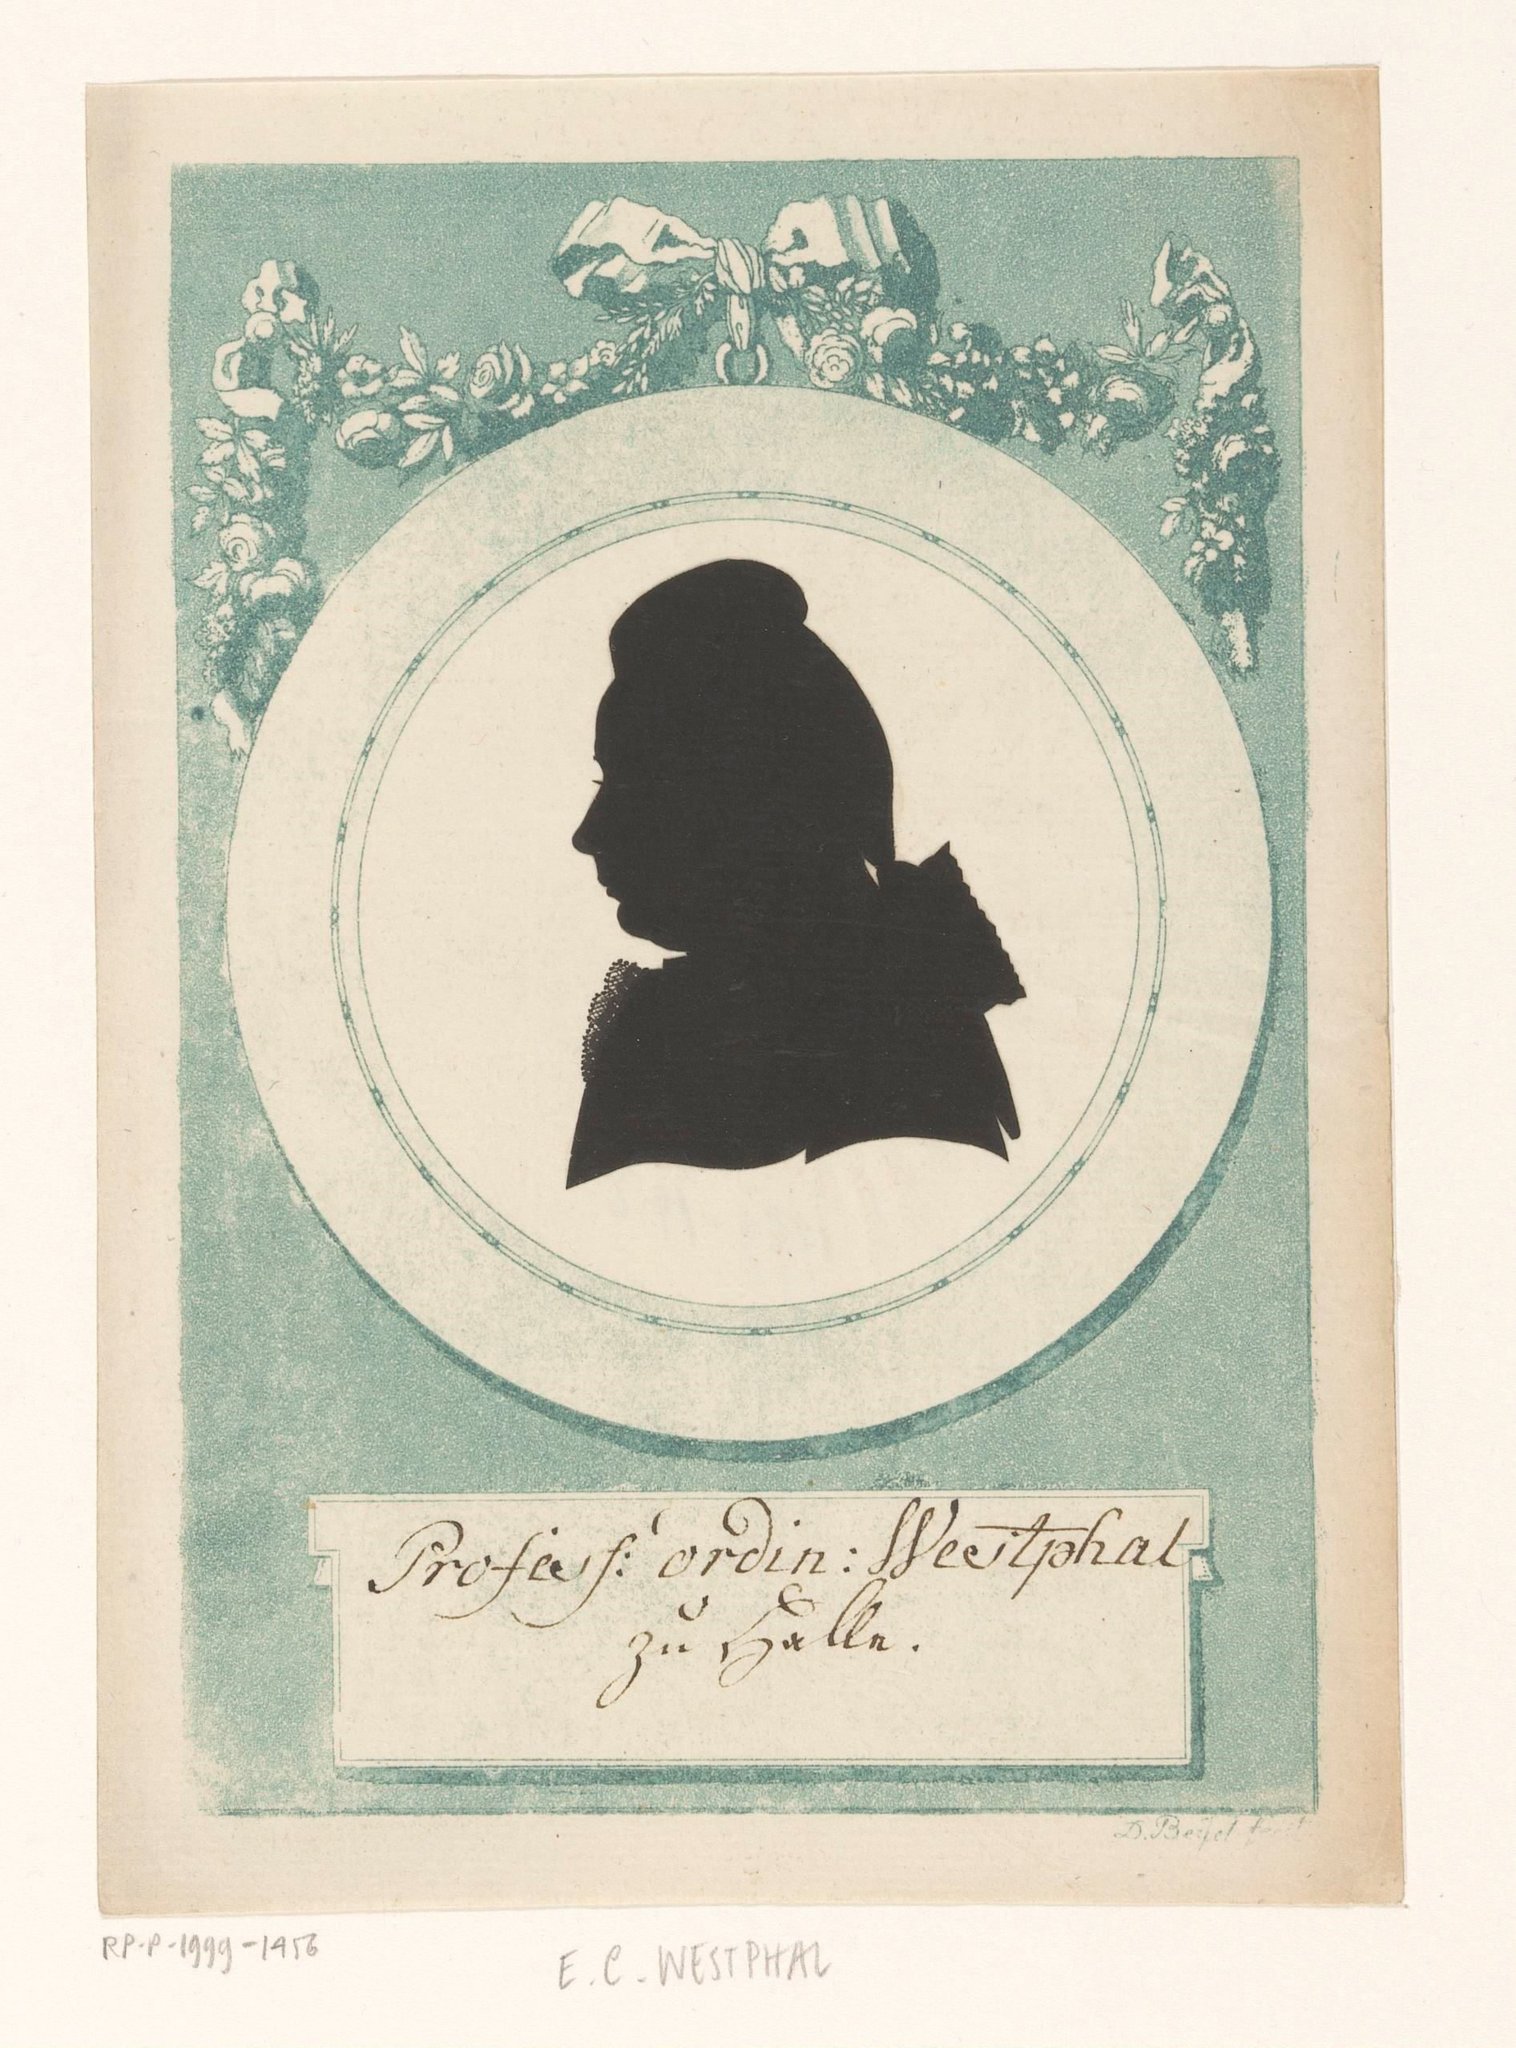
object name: print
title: Silhouetportret van Ernst Christian Westphal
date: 1785-1792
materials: ink, paper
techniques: aquatint, etching, pen, snipping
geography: munich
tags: historical persons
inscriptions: inscription: ‘Profess: ordin: Westphal / zu Halle’, collector's mark: Lugt 2228